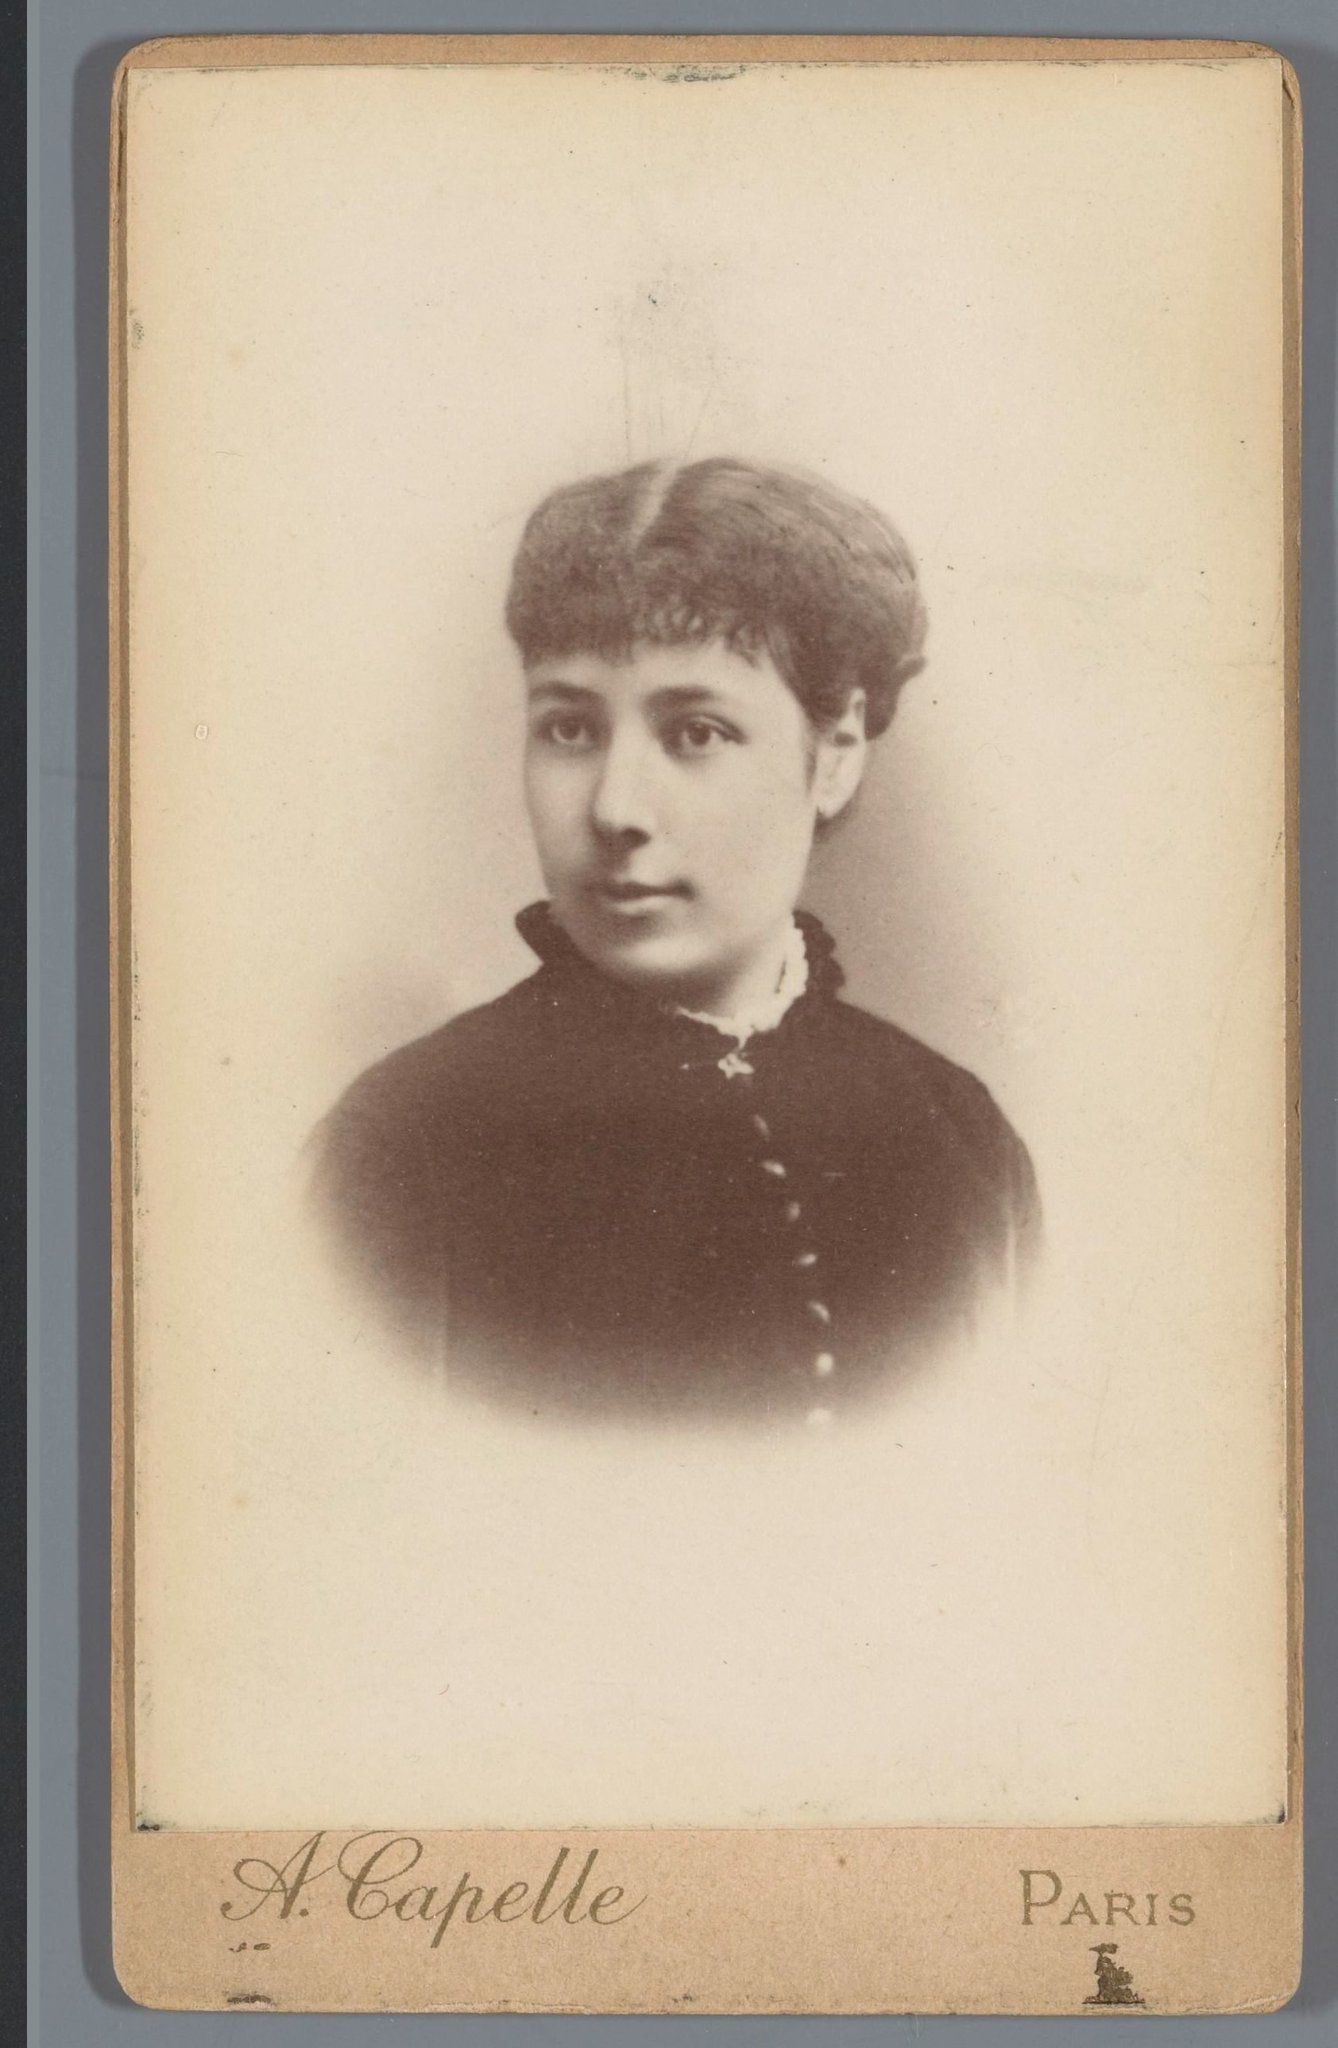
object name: photograph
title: Portret van een onbekende vrouw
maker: albert capelle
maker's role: fotograaf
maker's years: 1854-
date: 1884-1893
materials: cardboard, celluloid, paper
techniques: albumen print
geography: paris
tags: historical persons - bb - woman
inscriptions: inscription: ‘CÉLÉBRITÉS ARTISTIQUES/ CONTEMPORAINS/ PHOTOGRAPHIE/ ALEBRT CAPELLE/ D'ART/ PARIS/ 45, Rue Laffitte./ Tous les clichés sont conservés.’